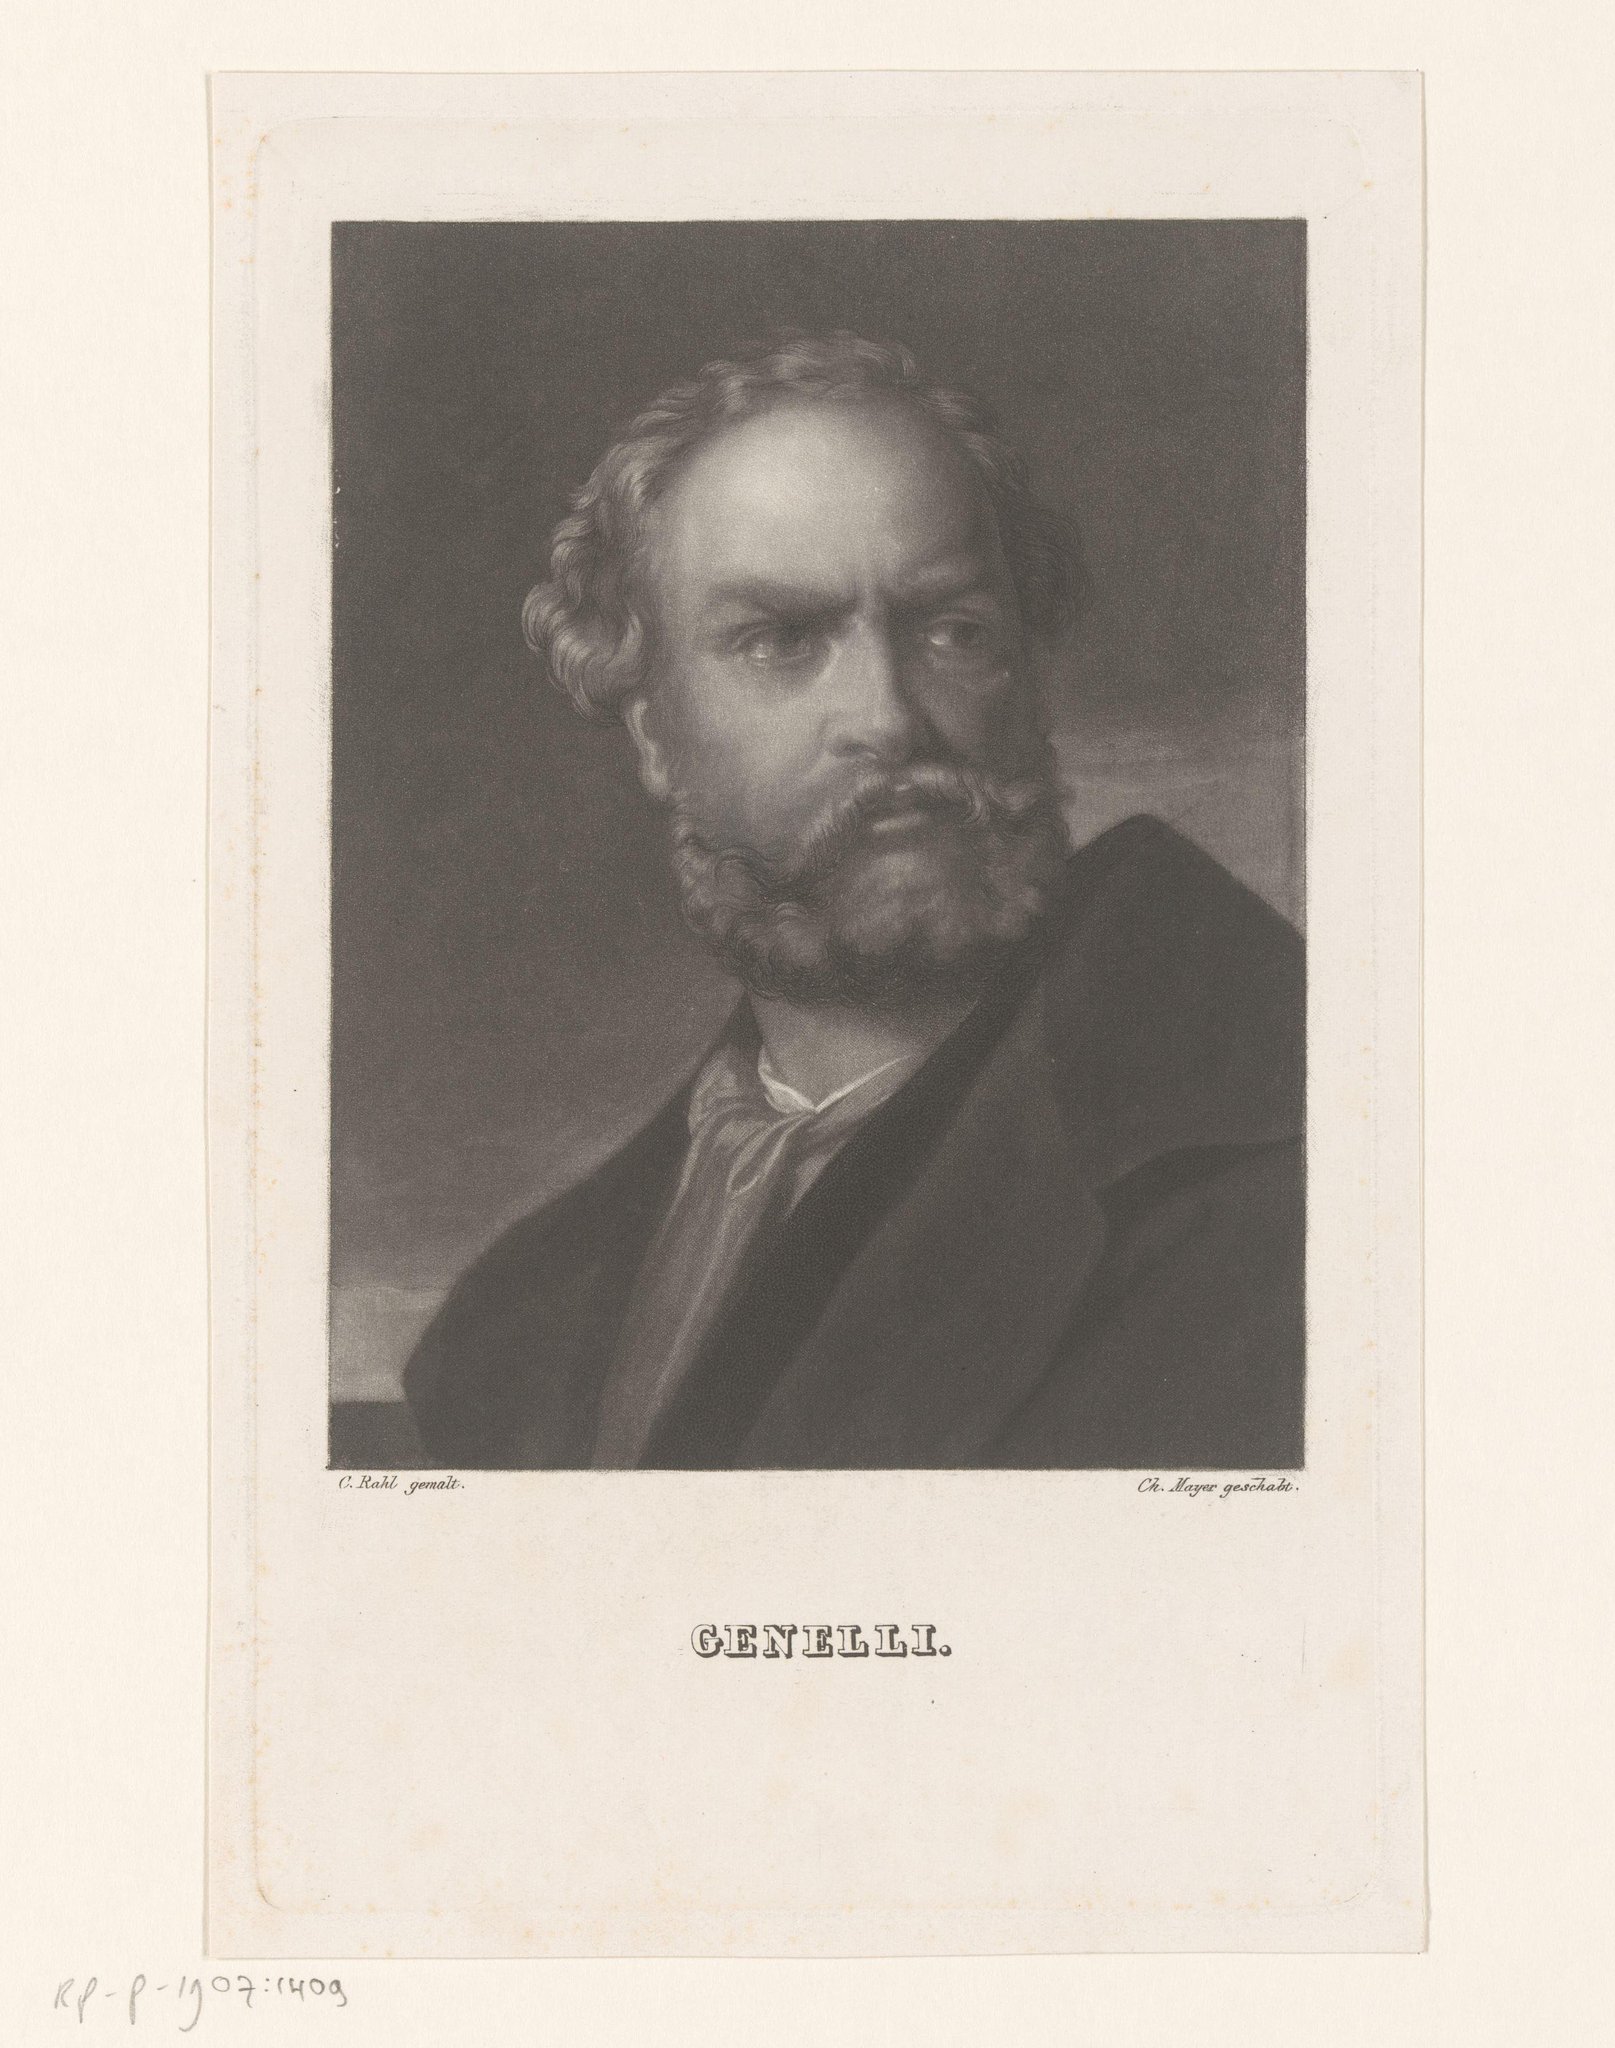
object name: print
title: Portret van Buonaventura Genelli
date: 1822-1870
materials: paper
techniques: mezzotint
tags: painter, draughtsman, portrait, self-portrait of artist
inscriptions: collector's mark: Lugt 2228